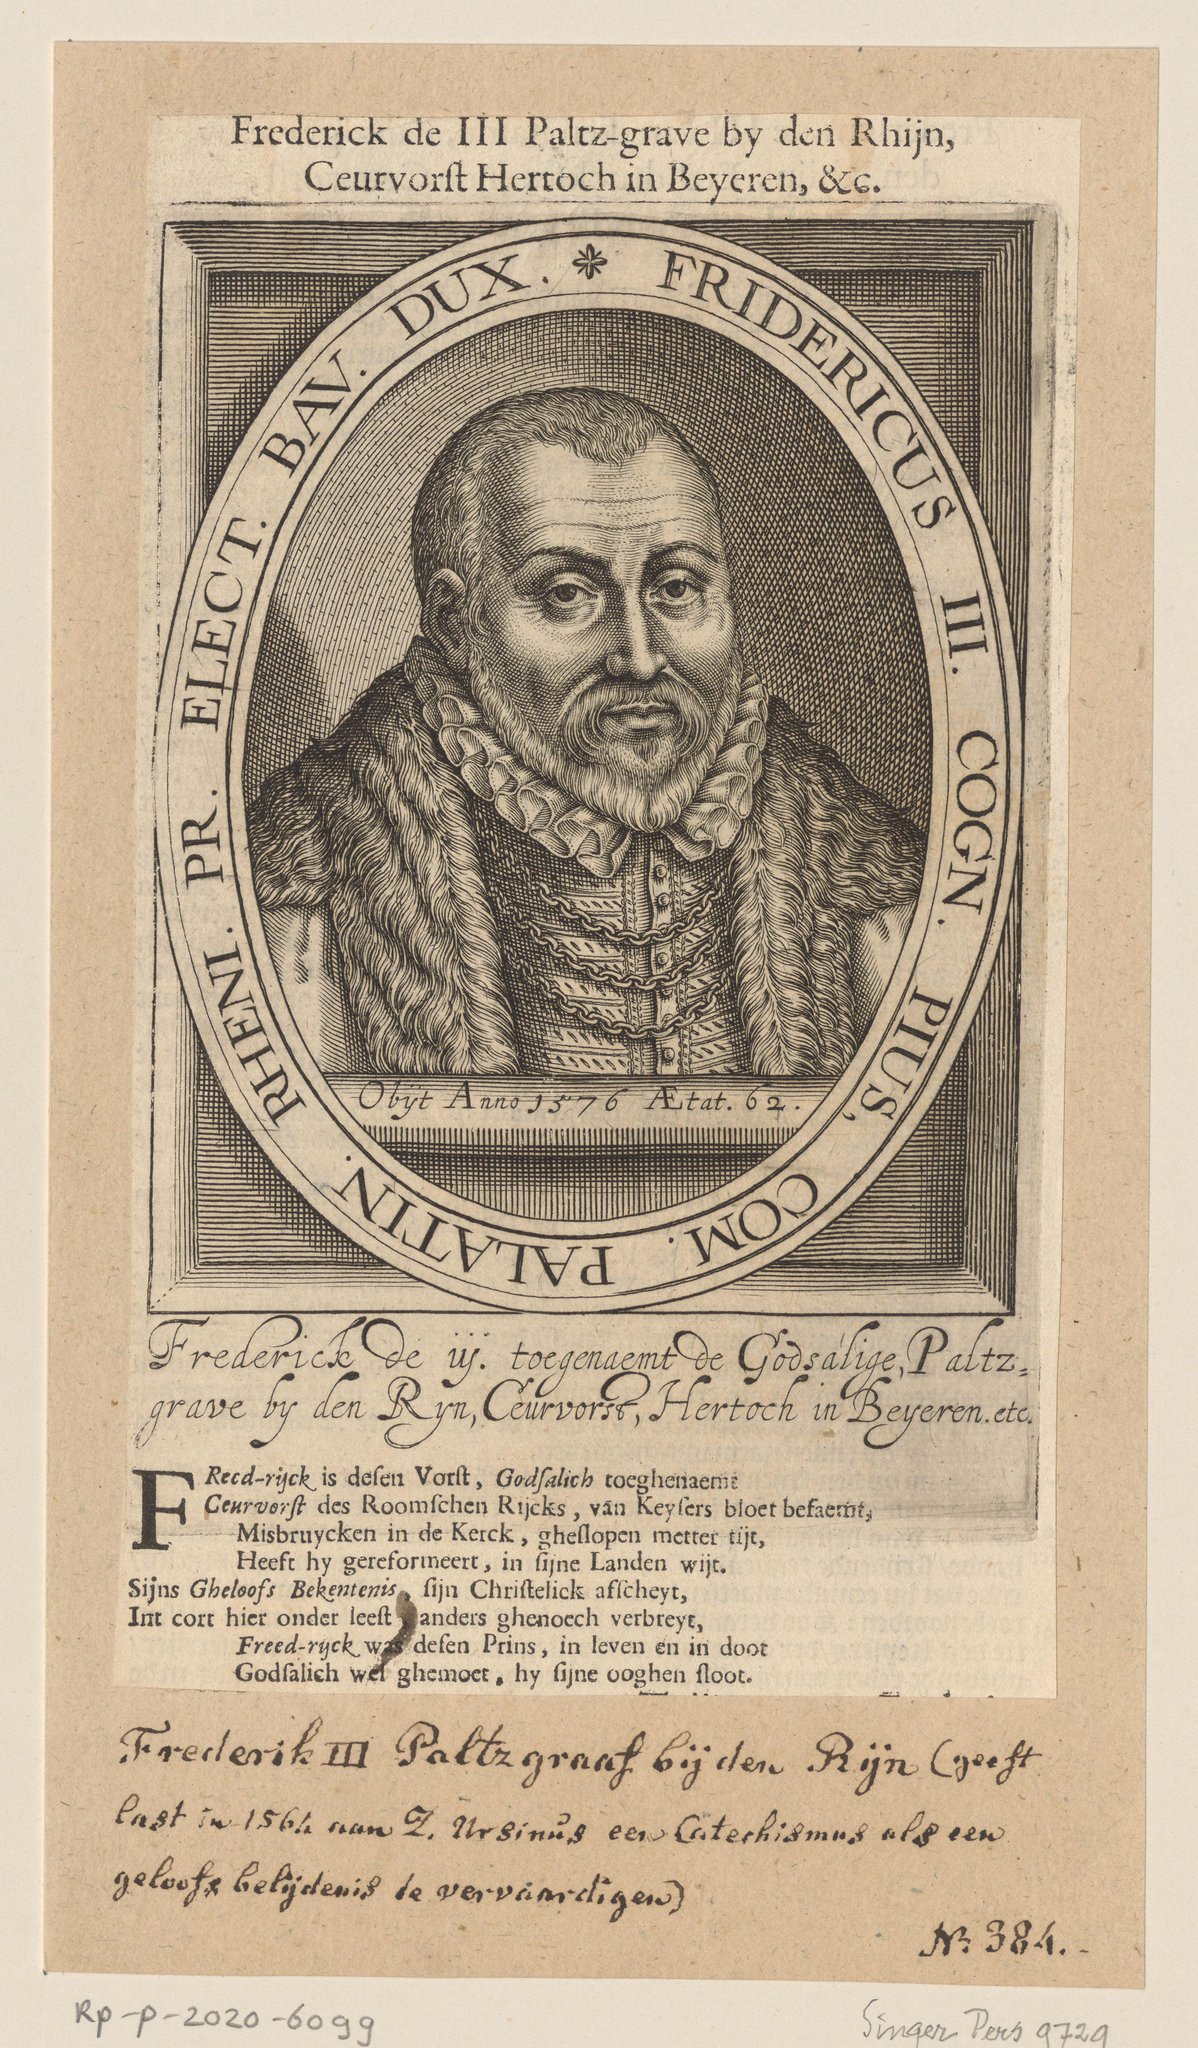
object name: print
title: Portret van Frederik III van de Palts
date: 1617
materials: paper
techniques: engraving, letterpress printing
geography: northern netherlands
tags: historical persons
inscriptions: inscription: ‘Frederik III Paltz graaf bij den Rijn (geeft/ last(?) in 1566 aan Z. Ursinus een Catechismus als een/ geloofsbelijdenis te vervaardigen)/ Nr. 384.’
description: Prent uit: Tooneel der beroemder hertogen princen graven ende krygs-helden van christenrijck binnen deze drij laetste eeuwen. Delft: Nicolaes de Clerck, 1617, p. 221.